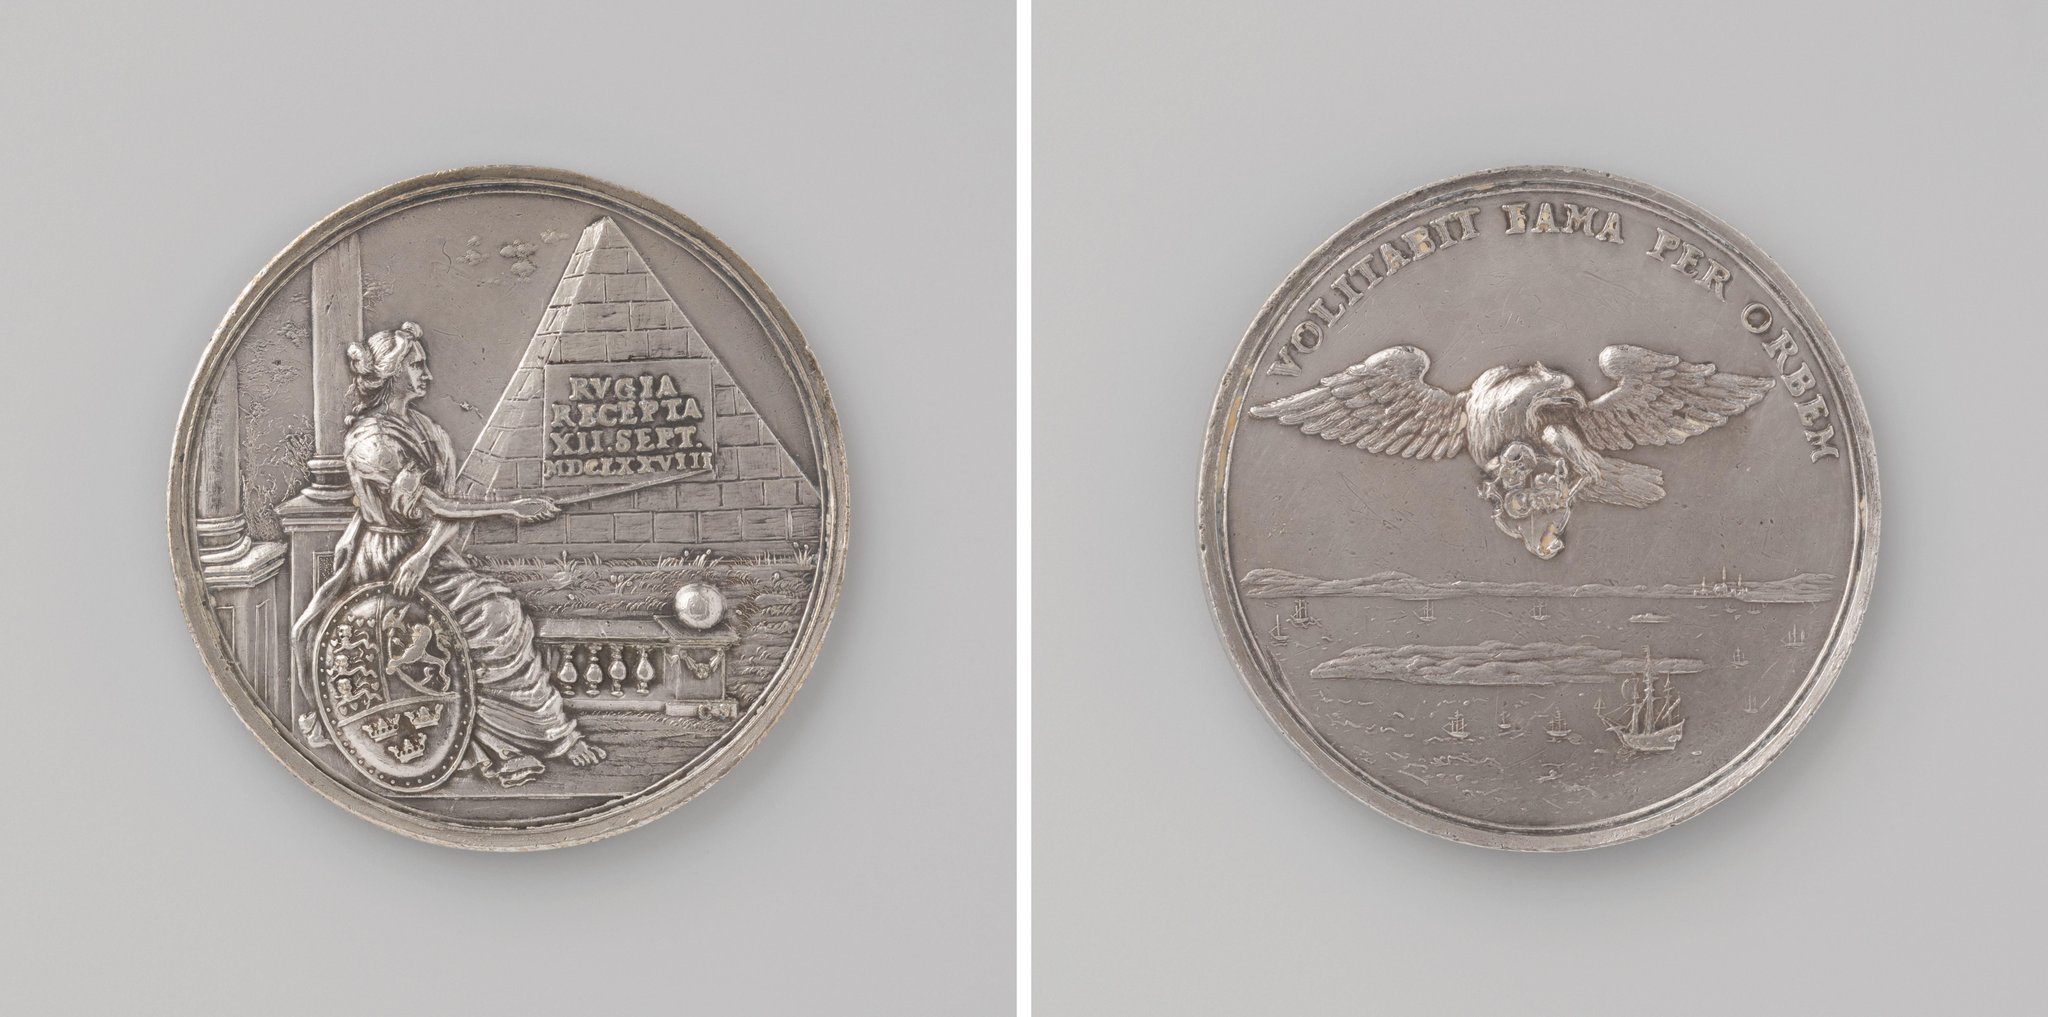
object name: history medal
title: Verovering van Rugen door de koning van Denemarken en de keurvorst van Brandenburg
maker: Anonymous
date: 1678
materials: silver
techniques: striking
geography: denmark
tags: frederik willem van brandenburg (i), copenhagen (city)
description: Zilveren penning. Voorzijde: Denemarken in gedaante van zittende vrouw met wapenschild wijst naar opschrift op piramide. Keerzijde: vliegende arend met schild met monogrammen van Christian V en Frederik Willem binnen omschrift